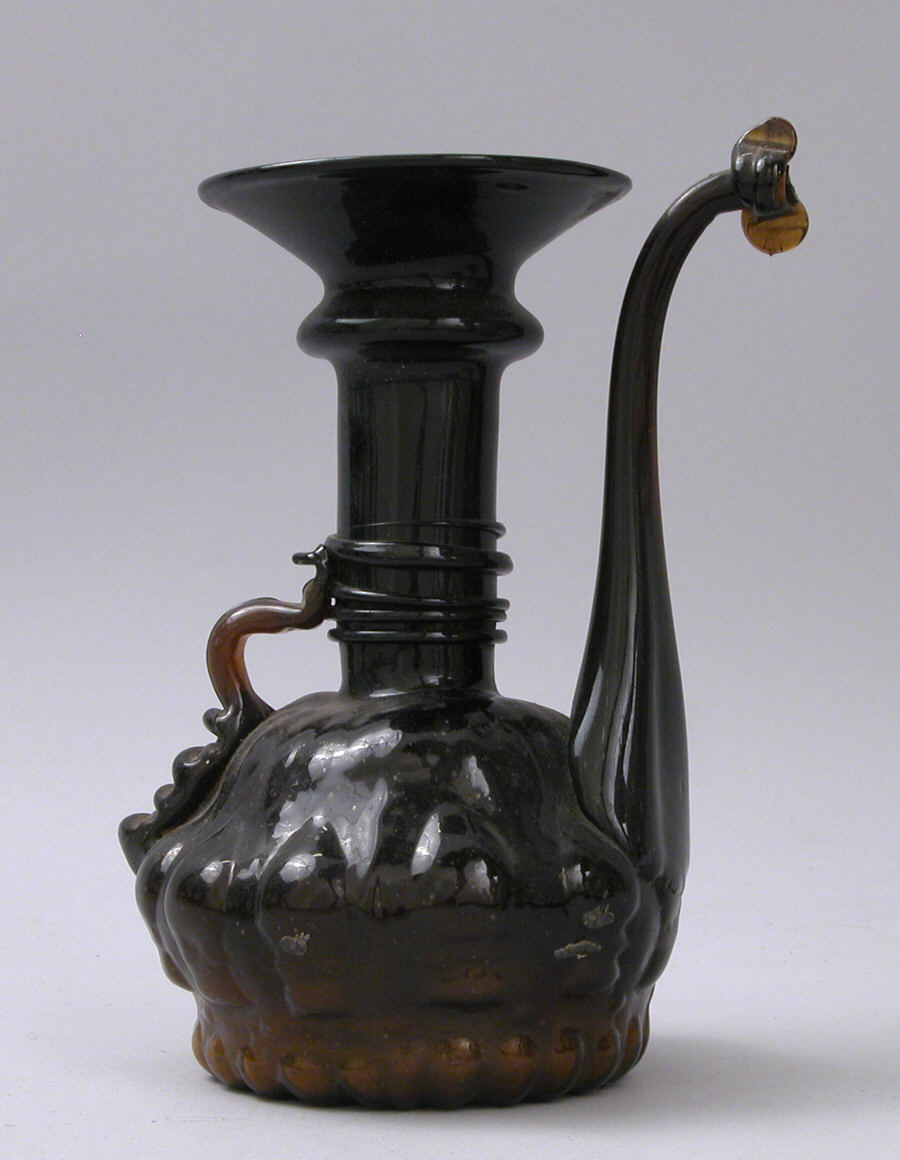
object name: ewer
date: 1701-1900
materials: glass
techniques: glassblowing, tooling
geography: iran